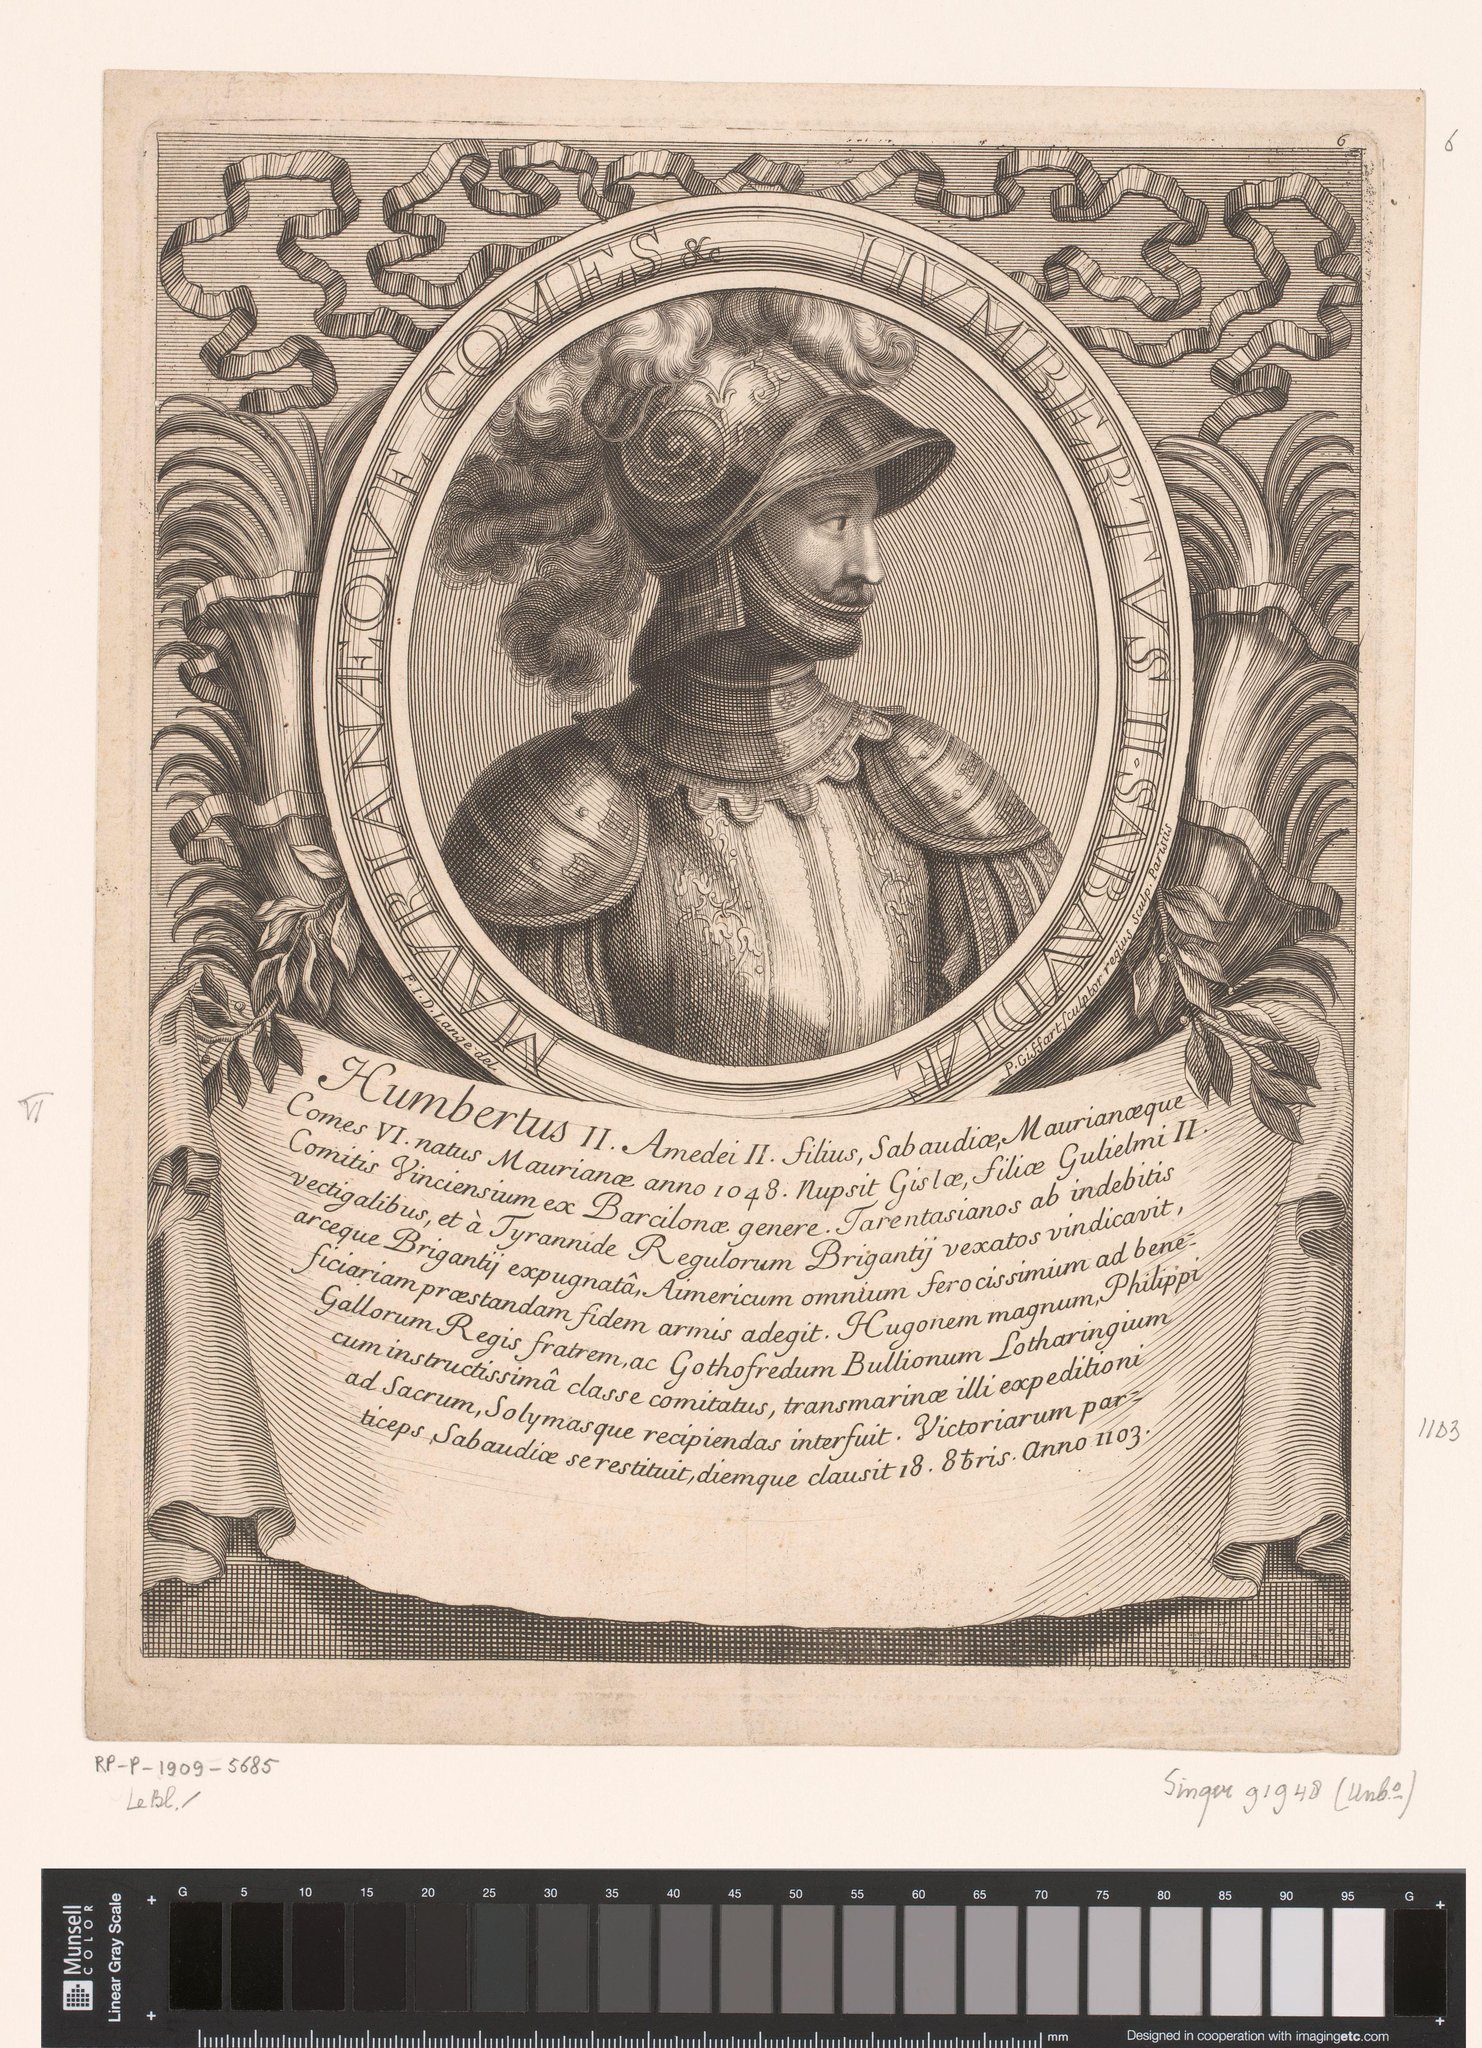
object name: print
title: Portretten van hertogen van Savoye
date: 1702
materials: paper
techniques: engraving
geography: paris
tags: historical persons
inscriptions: collector's mark: Lugt 2228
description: Maakt deel uit van een serie getiteld 'Augustae regiaeque Sabaudae domus Arbor gentilitia regiae celsitudini Victori Amedeo II' met portretten door Giffart en Tasnière van leden van het Huis van Savoye, uitgegeven in 1702 door Francesco Maria Ferrero di Lavriano.